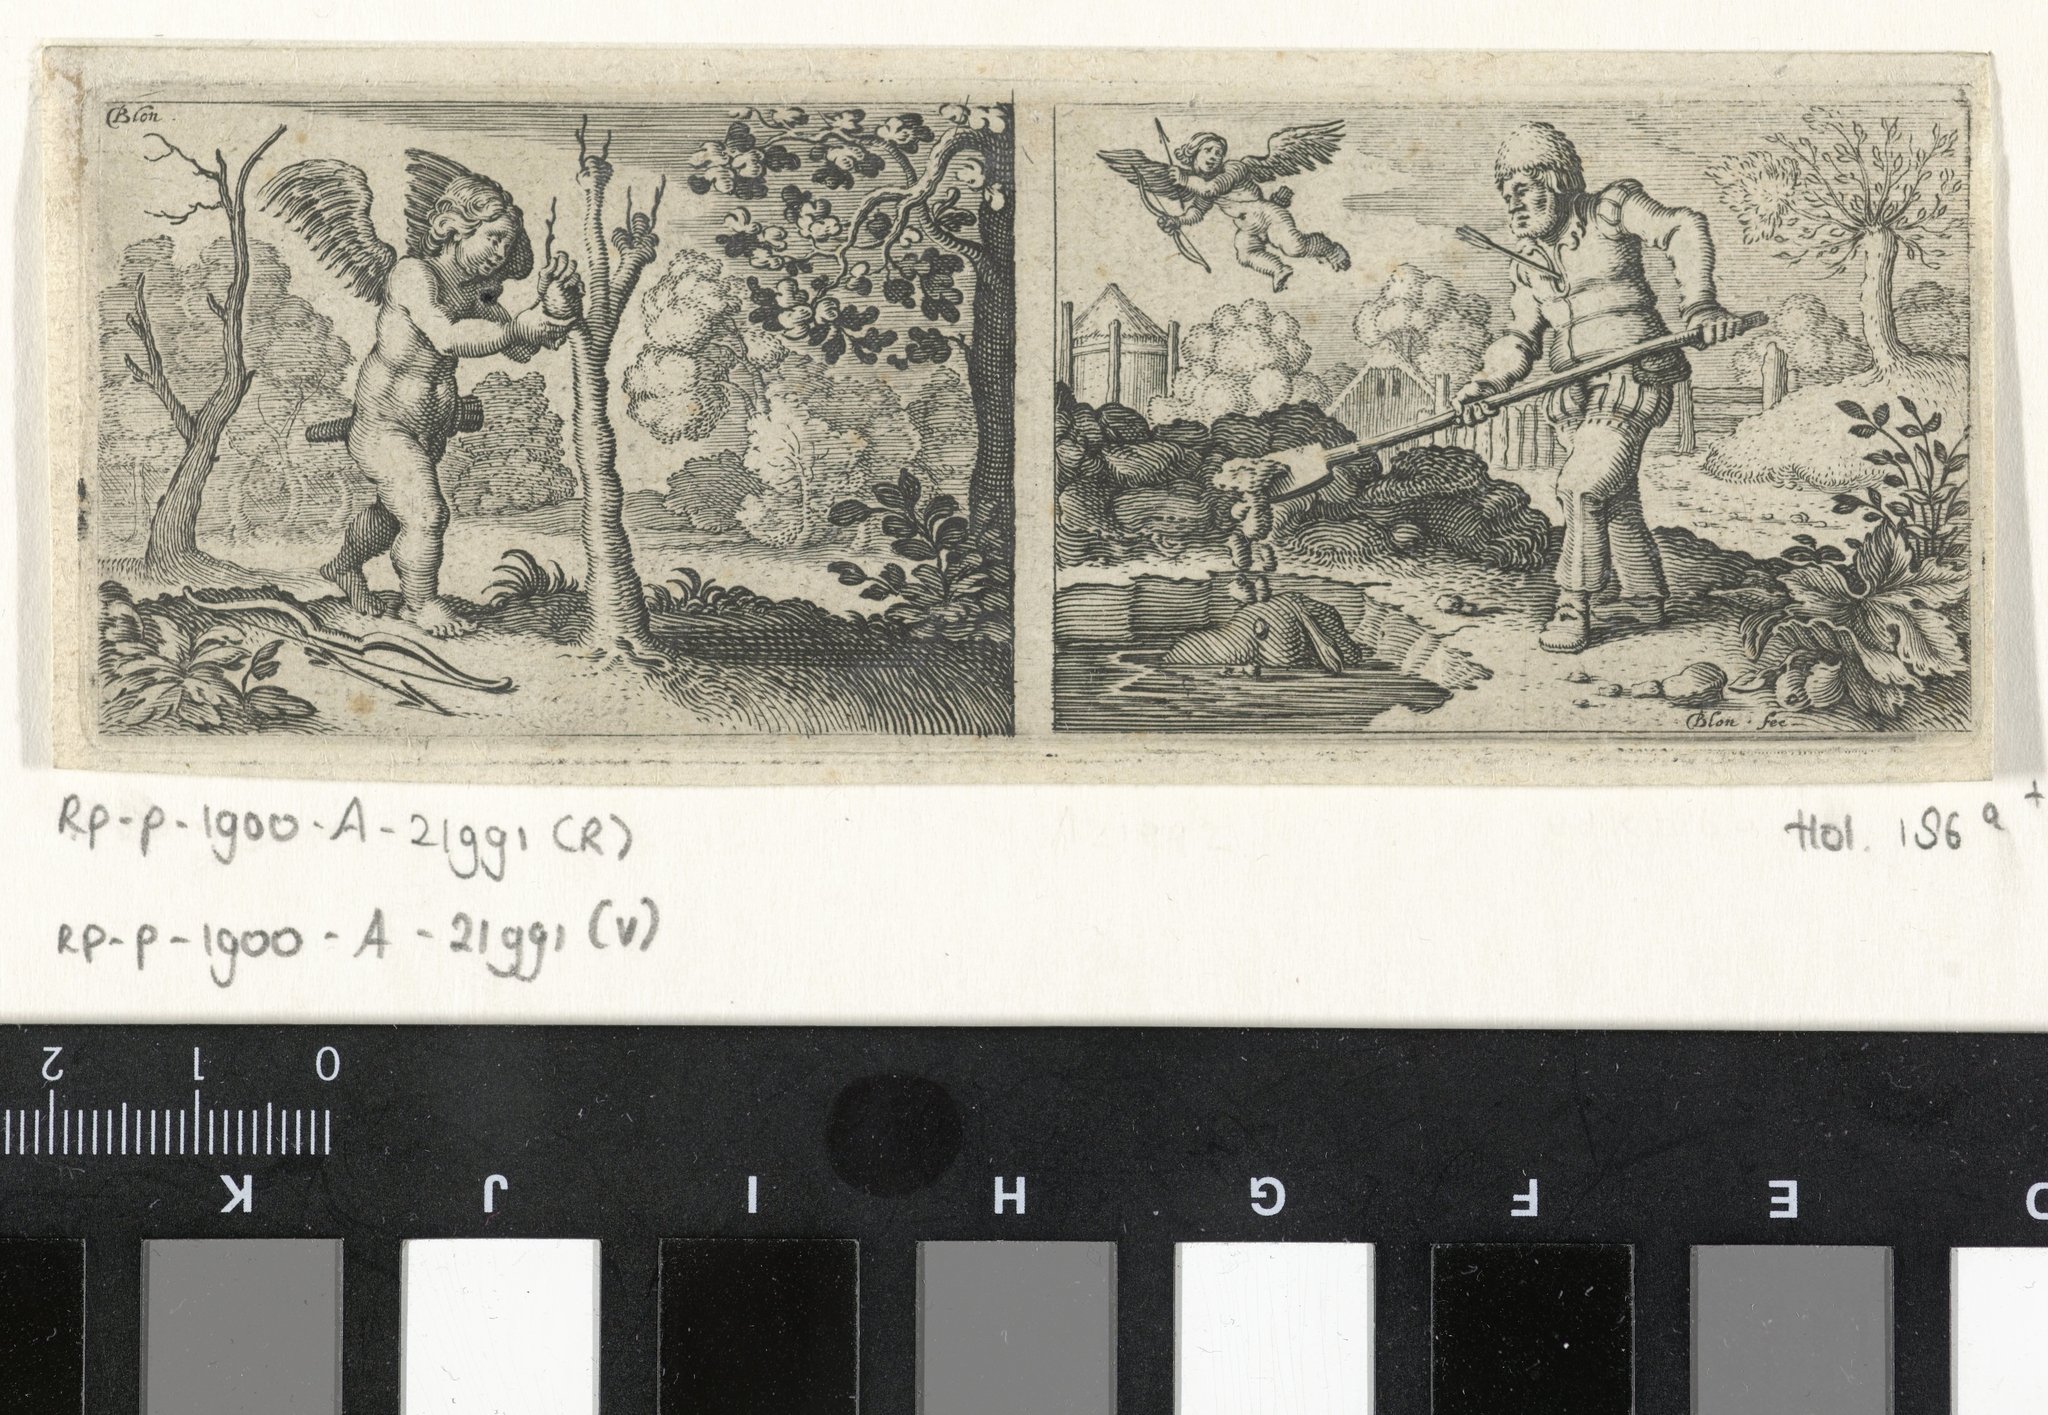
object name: print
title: Amor als tuinman / Verdronken paard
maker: michiel le blon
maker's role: print maker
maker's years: 1587-1656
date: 1616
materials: paper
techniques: engraving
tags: accidental death ~ water (+ variant), (story of) cupid, amor (eros), picking fruit, horse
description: Twee voorstellingen van één plaat. Links: Amor heeft zijn pijl en boog neergelegd en trekt een vrucht van een boom. Rechts: Een boer, wiens hart is doorboord met de pijl van Amor, begraaft met een schep zijn verdronken paard in een kuil. In de lucht vliegt Amor. De prenten maken deel uit van een serie prenten met liefdesemblemen.